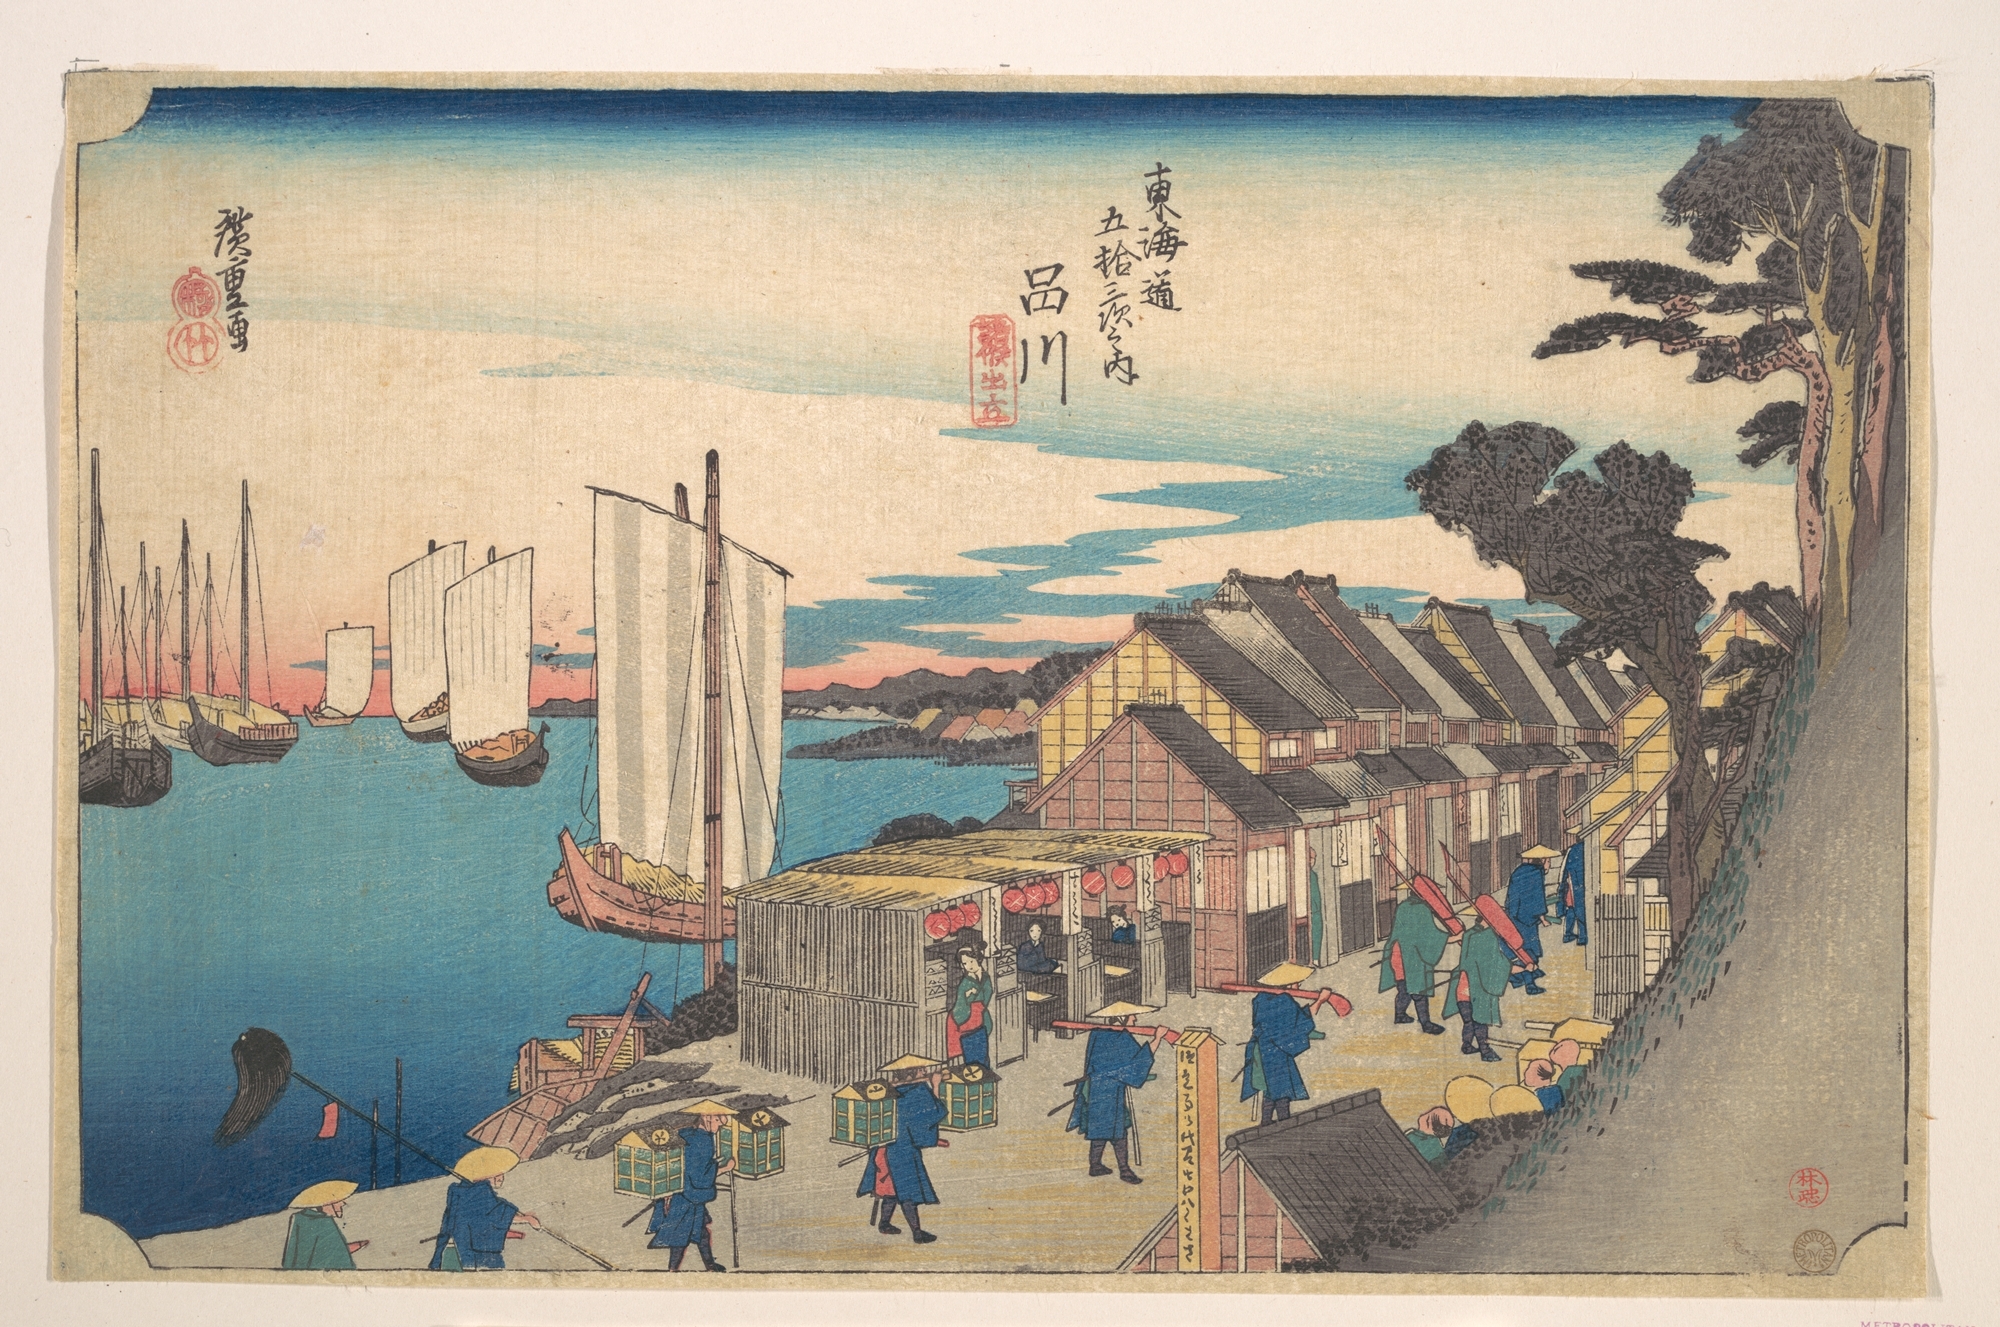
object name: print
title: Shinagawa; Shoko Detachi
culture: japanese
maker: utagawa hiroshige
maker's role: artist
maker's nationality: japanese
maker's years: 1797-1858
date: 1834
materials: ink, paper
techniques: woodblock print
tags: human figures,rivers,trees,markets,boats